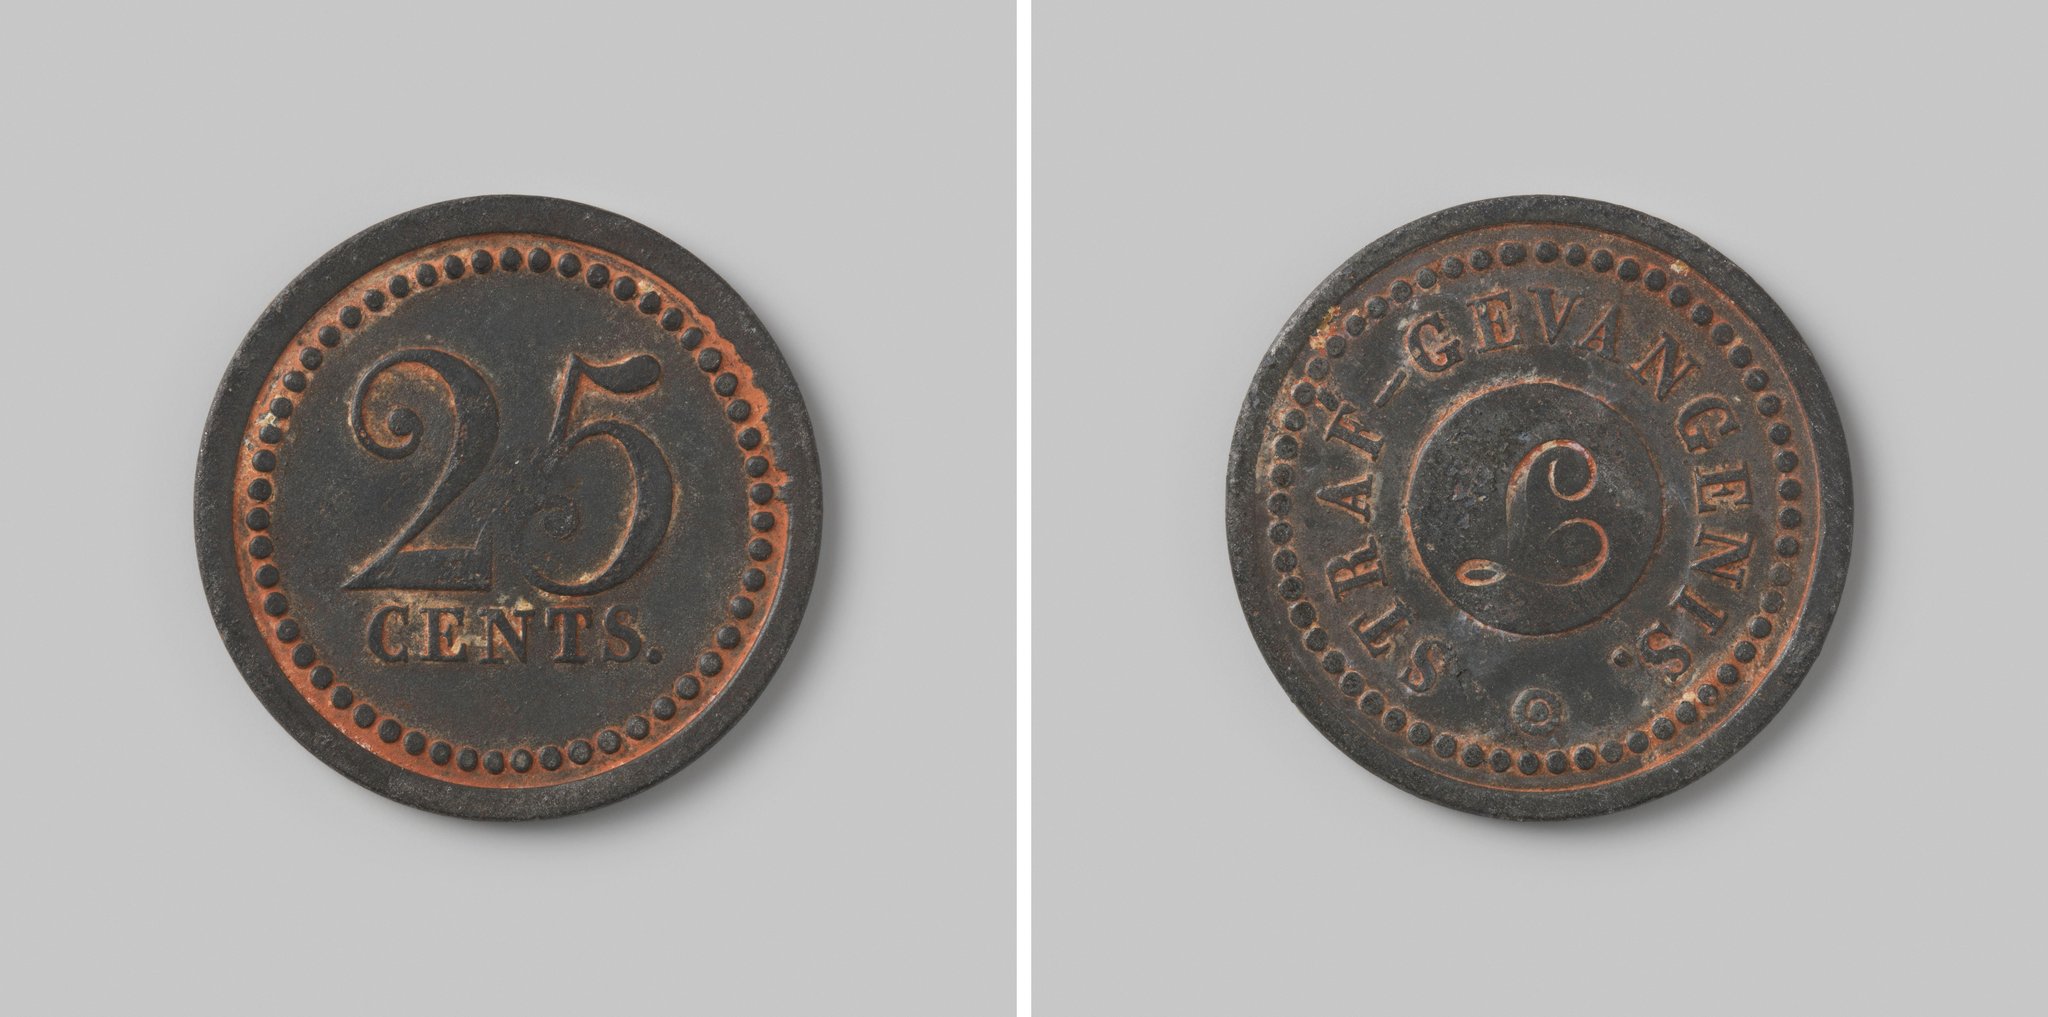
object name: vijfentwintig cent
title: Betaalpenning voor Nederlandse strafgevangenissen, vijfentwintig cents gemerkt L (Leeuwarden)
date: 1834-1861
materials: zinc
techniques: striking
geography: utrecht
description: Zinken betaalpenning, op de voorzijde een verhoogd middenveld met instempeling L, met omschrift, op de keerzijde de waarde in twee regels.